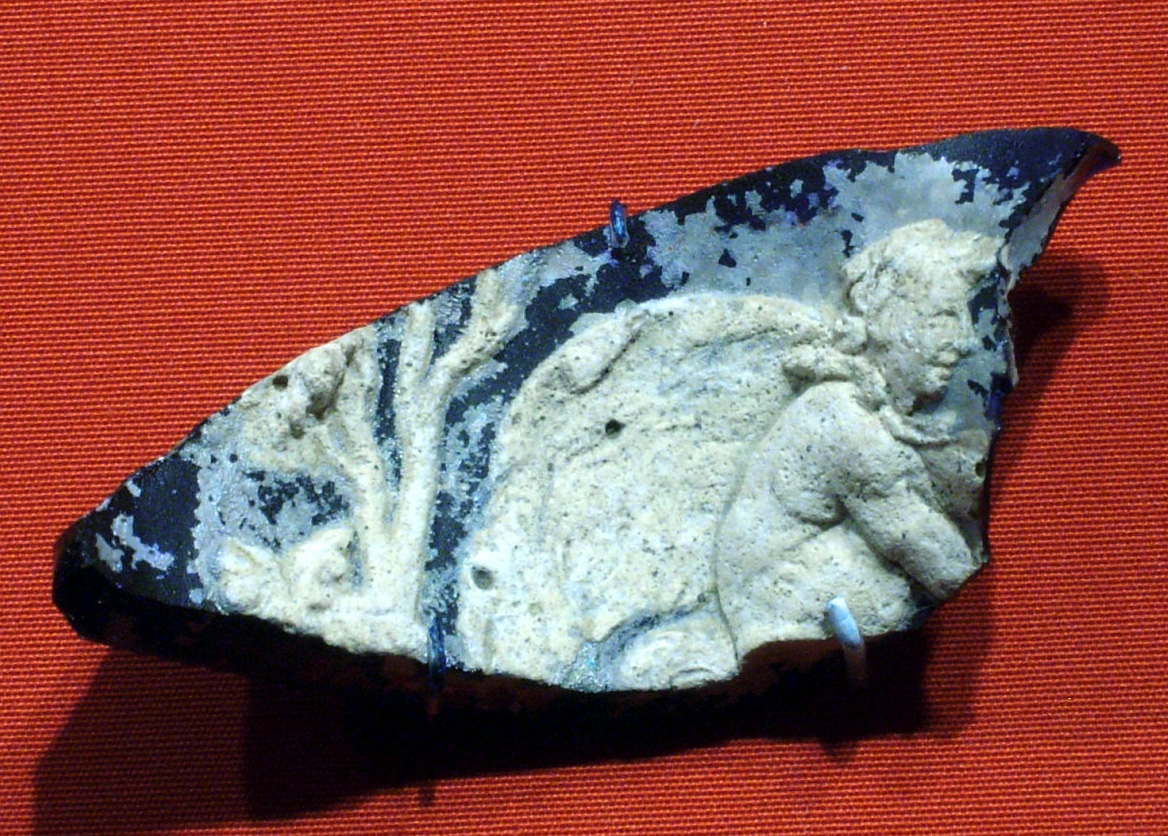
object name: cameo, satyr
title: Cameo fragment with a satyr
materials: glass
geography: egypt or italy